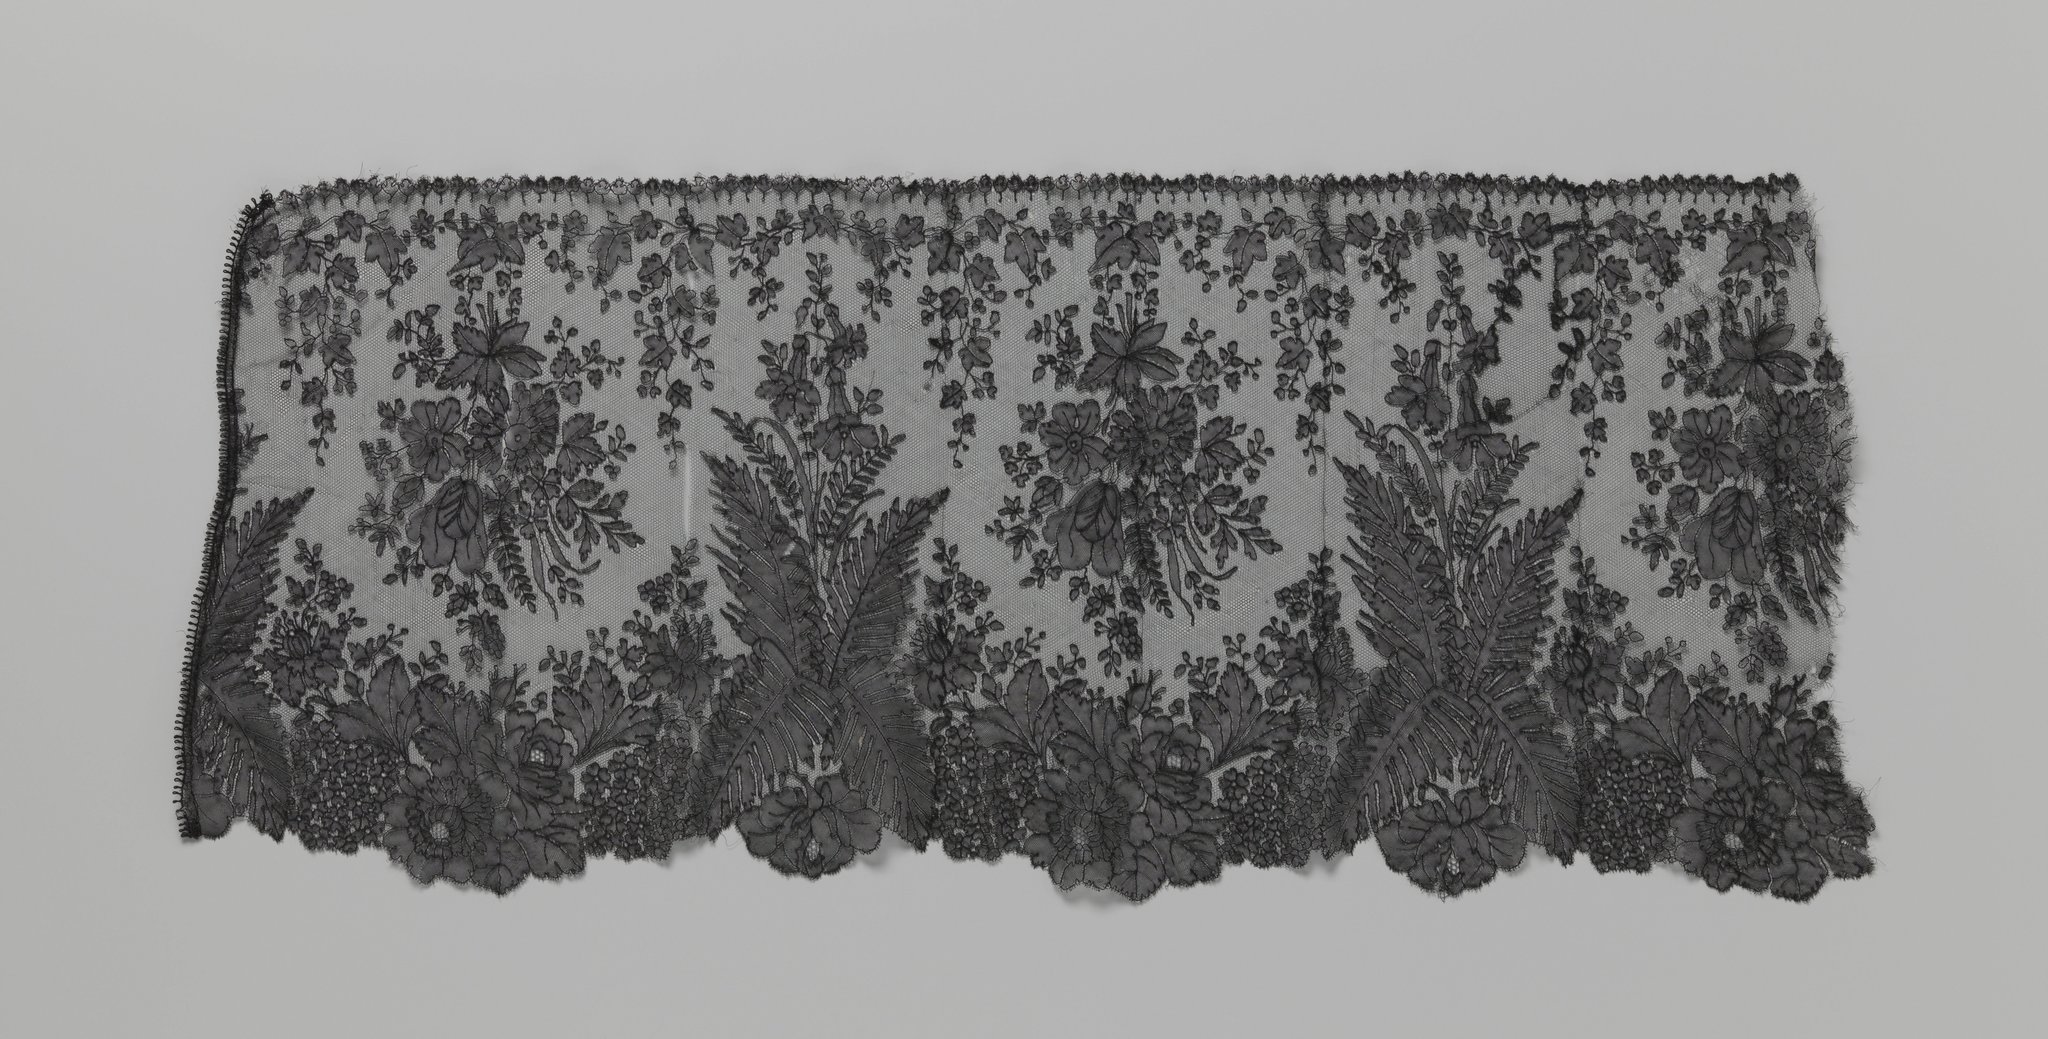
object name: strip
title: Japonstrook van kloskant met varens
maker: Anonymous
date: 1850-1855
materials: silk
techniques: lace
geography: france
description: Japonstrook van zwarte kloskant: Chantilly-kant. Op een leeg mazenfond staat een gesloten rand met schulpen, gevuld met een guirlande van bloemen en bladeren. Op de snijpunten staat een kleine schulp met een hangende roos, waarboven een spits boeket oprijst van vier grote varenbladeren en een bloemtak, die tot aan de bovenrand reikt. Hier loopt een horizontale klimoprank met hangende takjes, terwijl op het veld boven de grote schulp van deze klimoprank een groot boeket afhangt, onder andere met een tulp.